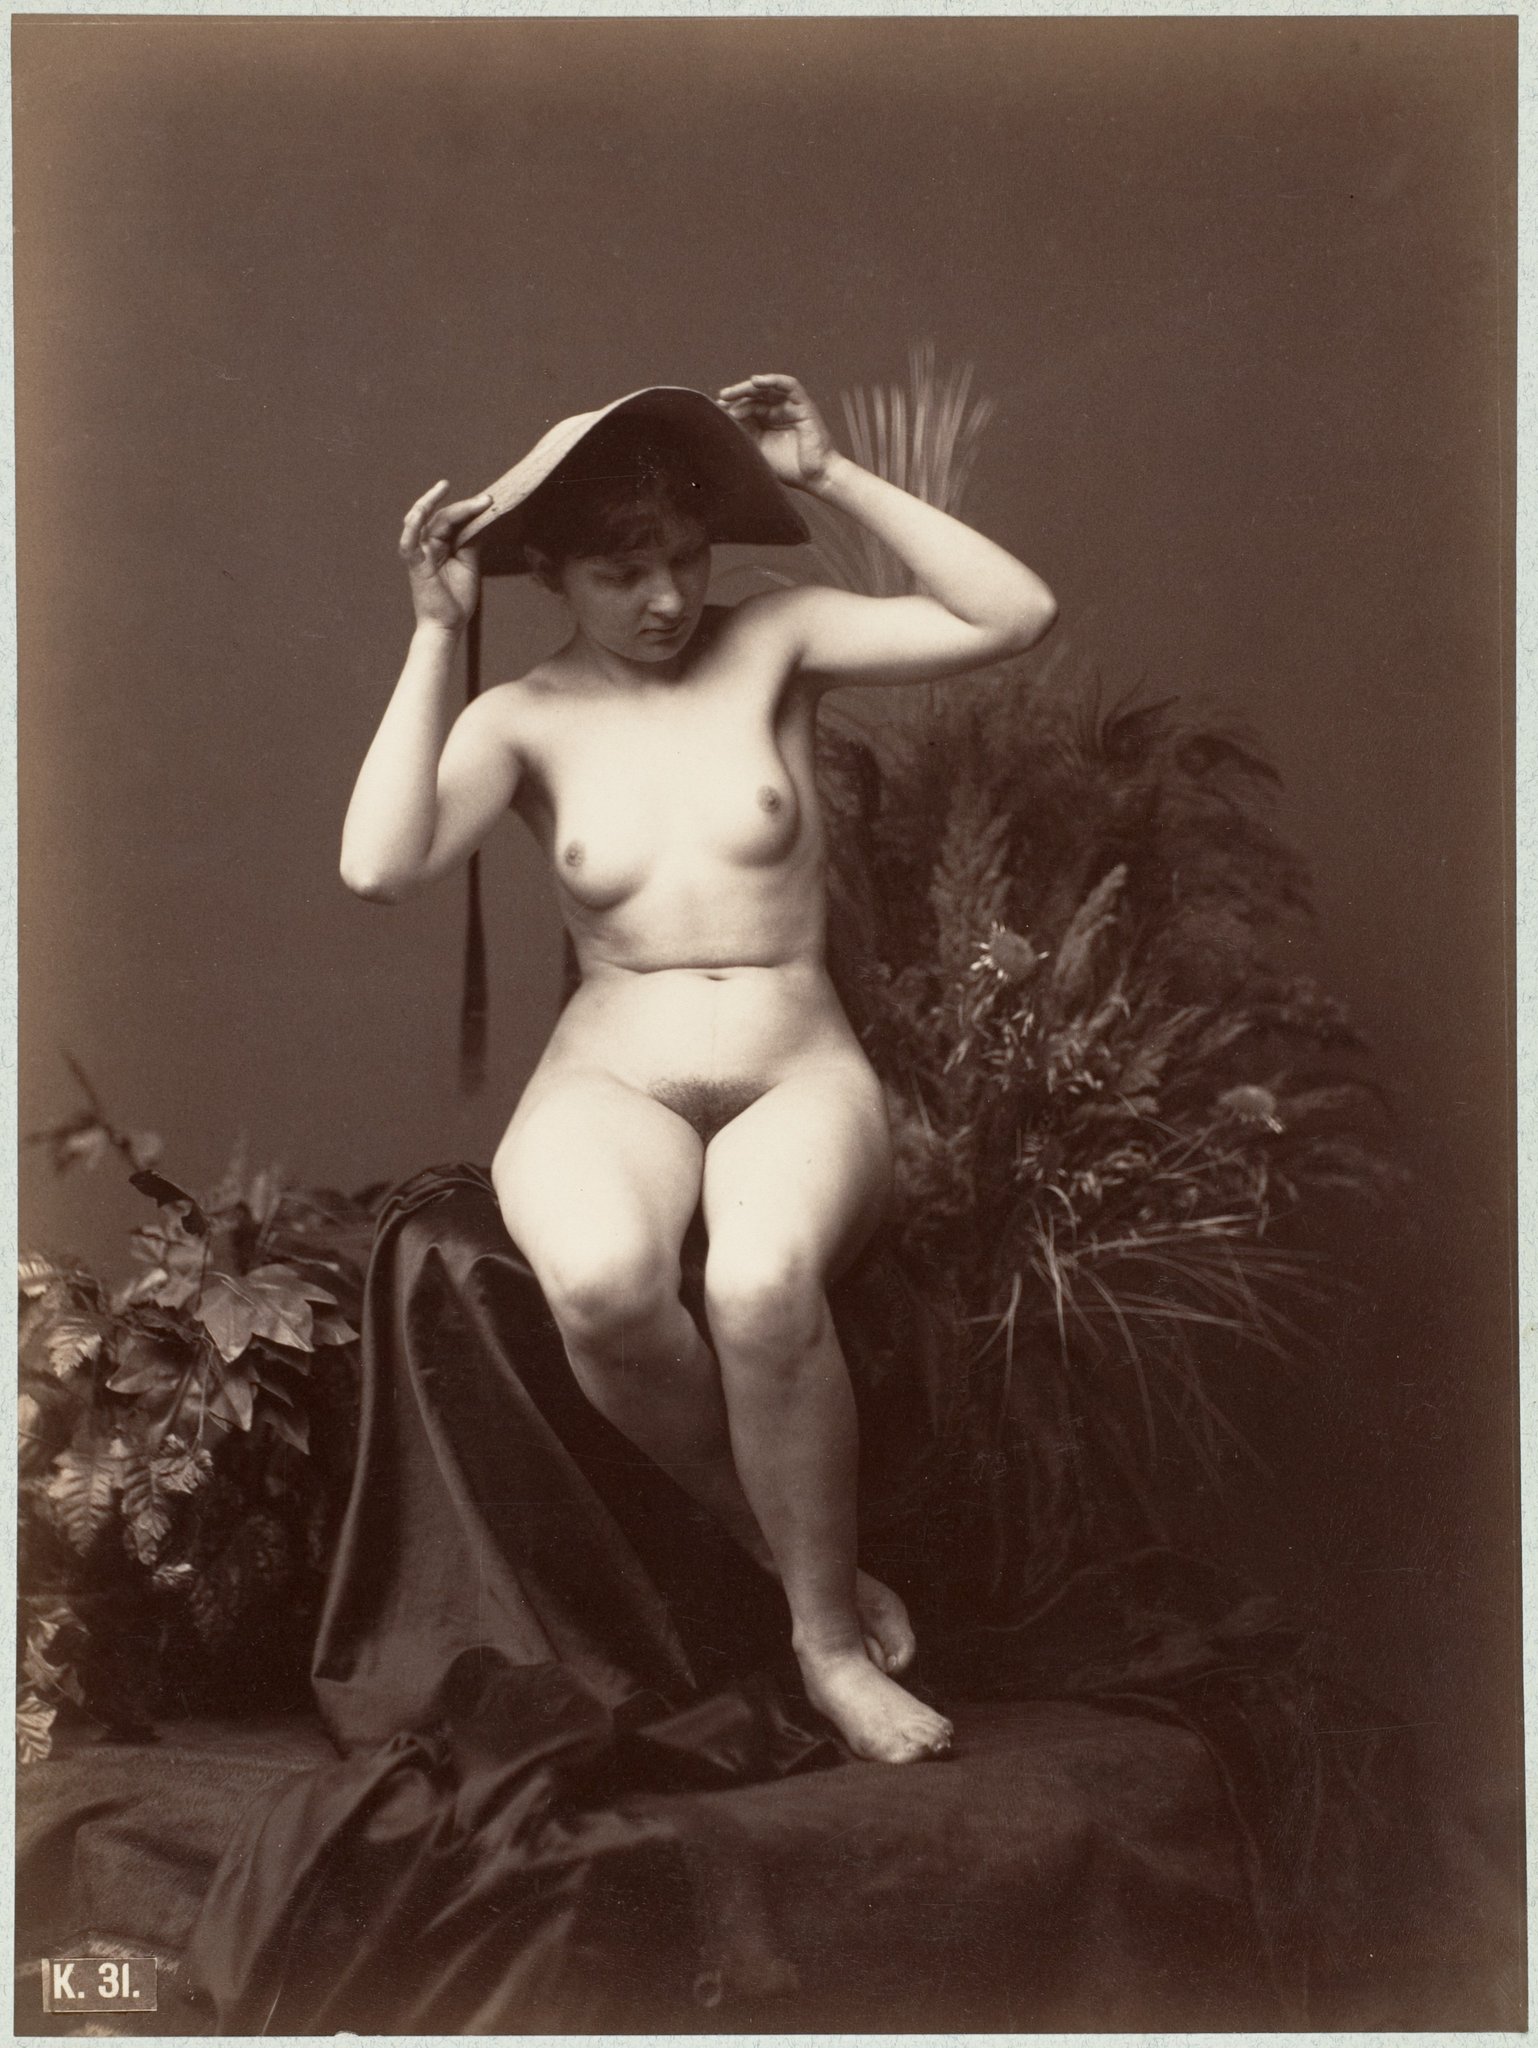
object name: photograph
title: [Nude Woman with Hat in Studio]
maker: Anonymous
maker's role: artist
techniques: albumen silver print, glass negative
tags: female nudes